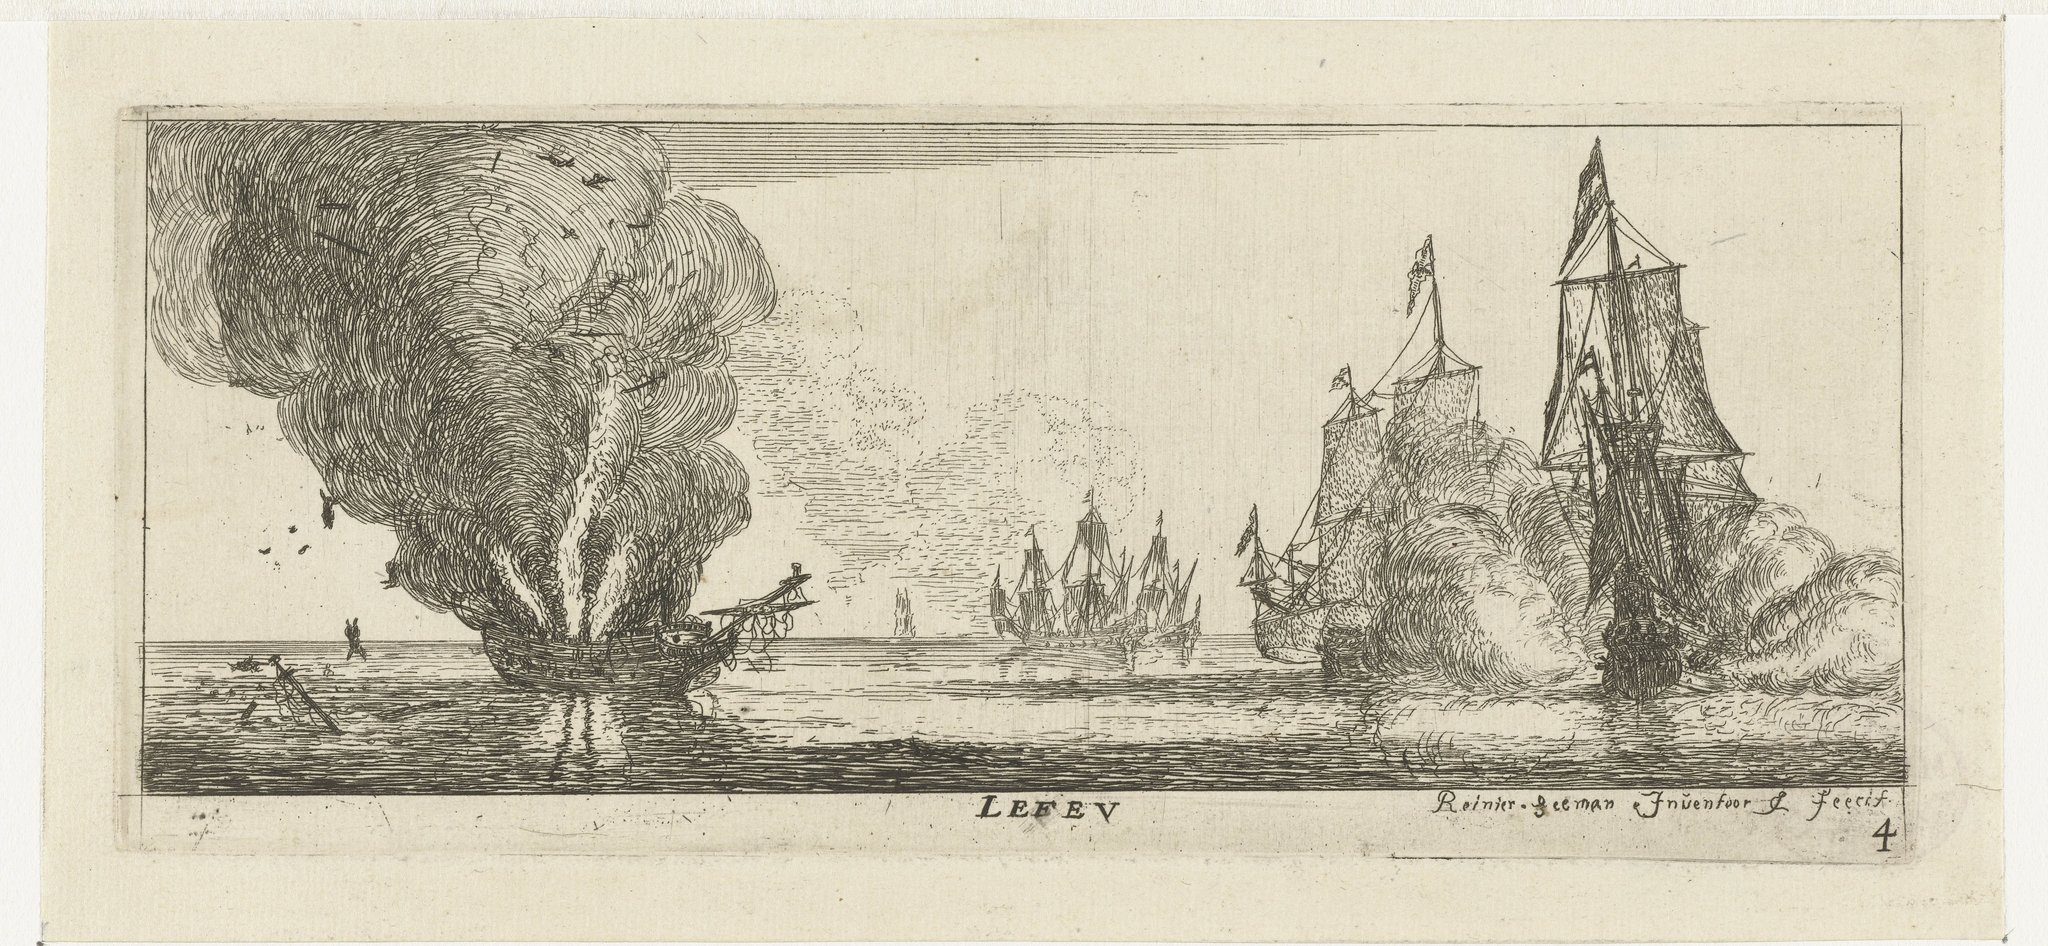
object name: print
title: Le Feu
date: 1651-1662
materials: paper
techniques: etching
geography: netherlands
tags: fire (one of the four elements), battle (+ sailing-ships)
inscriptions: collector's mark: Lugt 12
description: Zeeslag, een oorlogsschip vuurt kanonnen af, een ander schip ontploft en staat in brand.